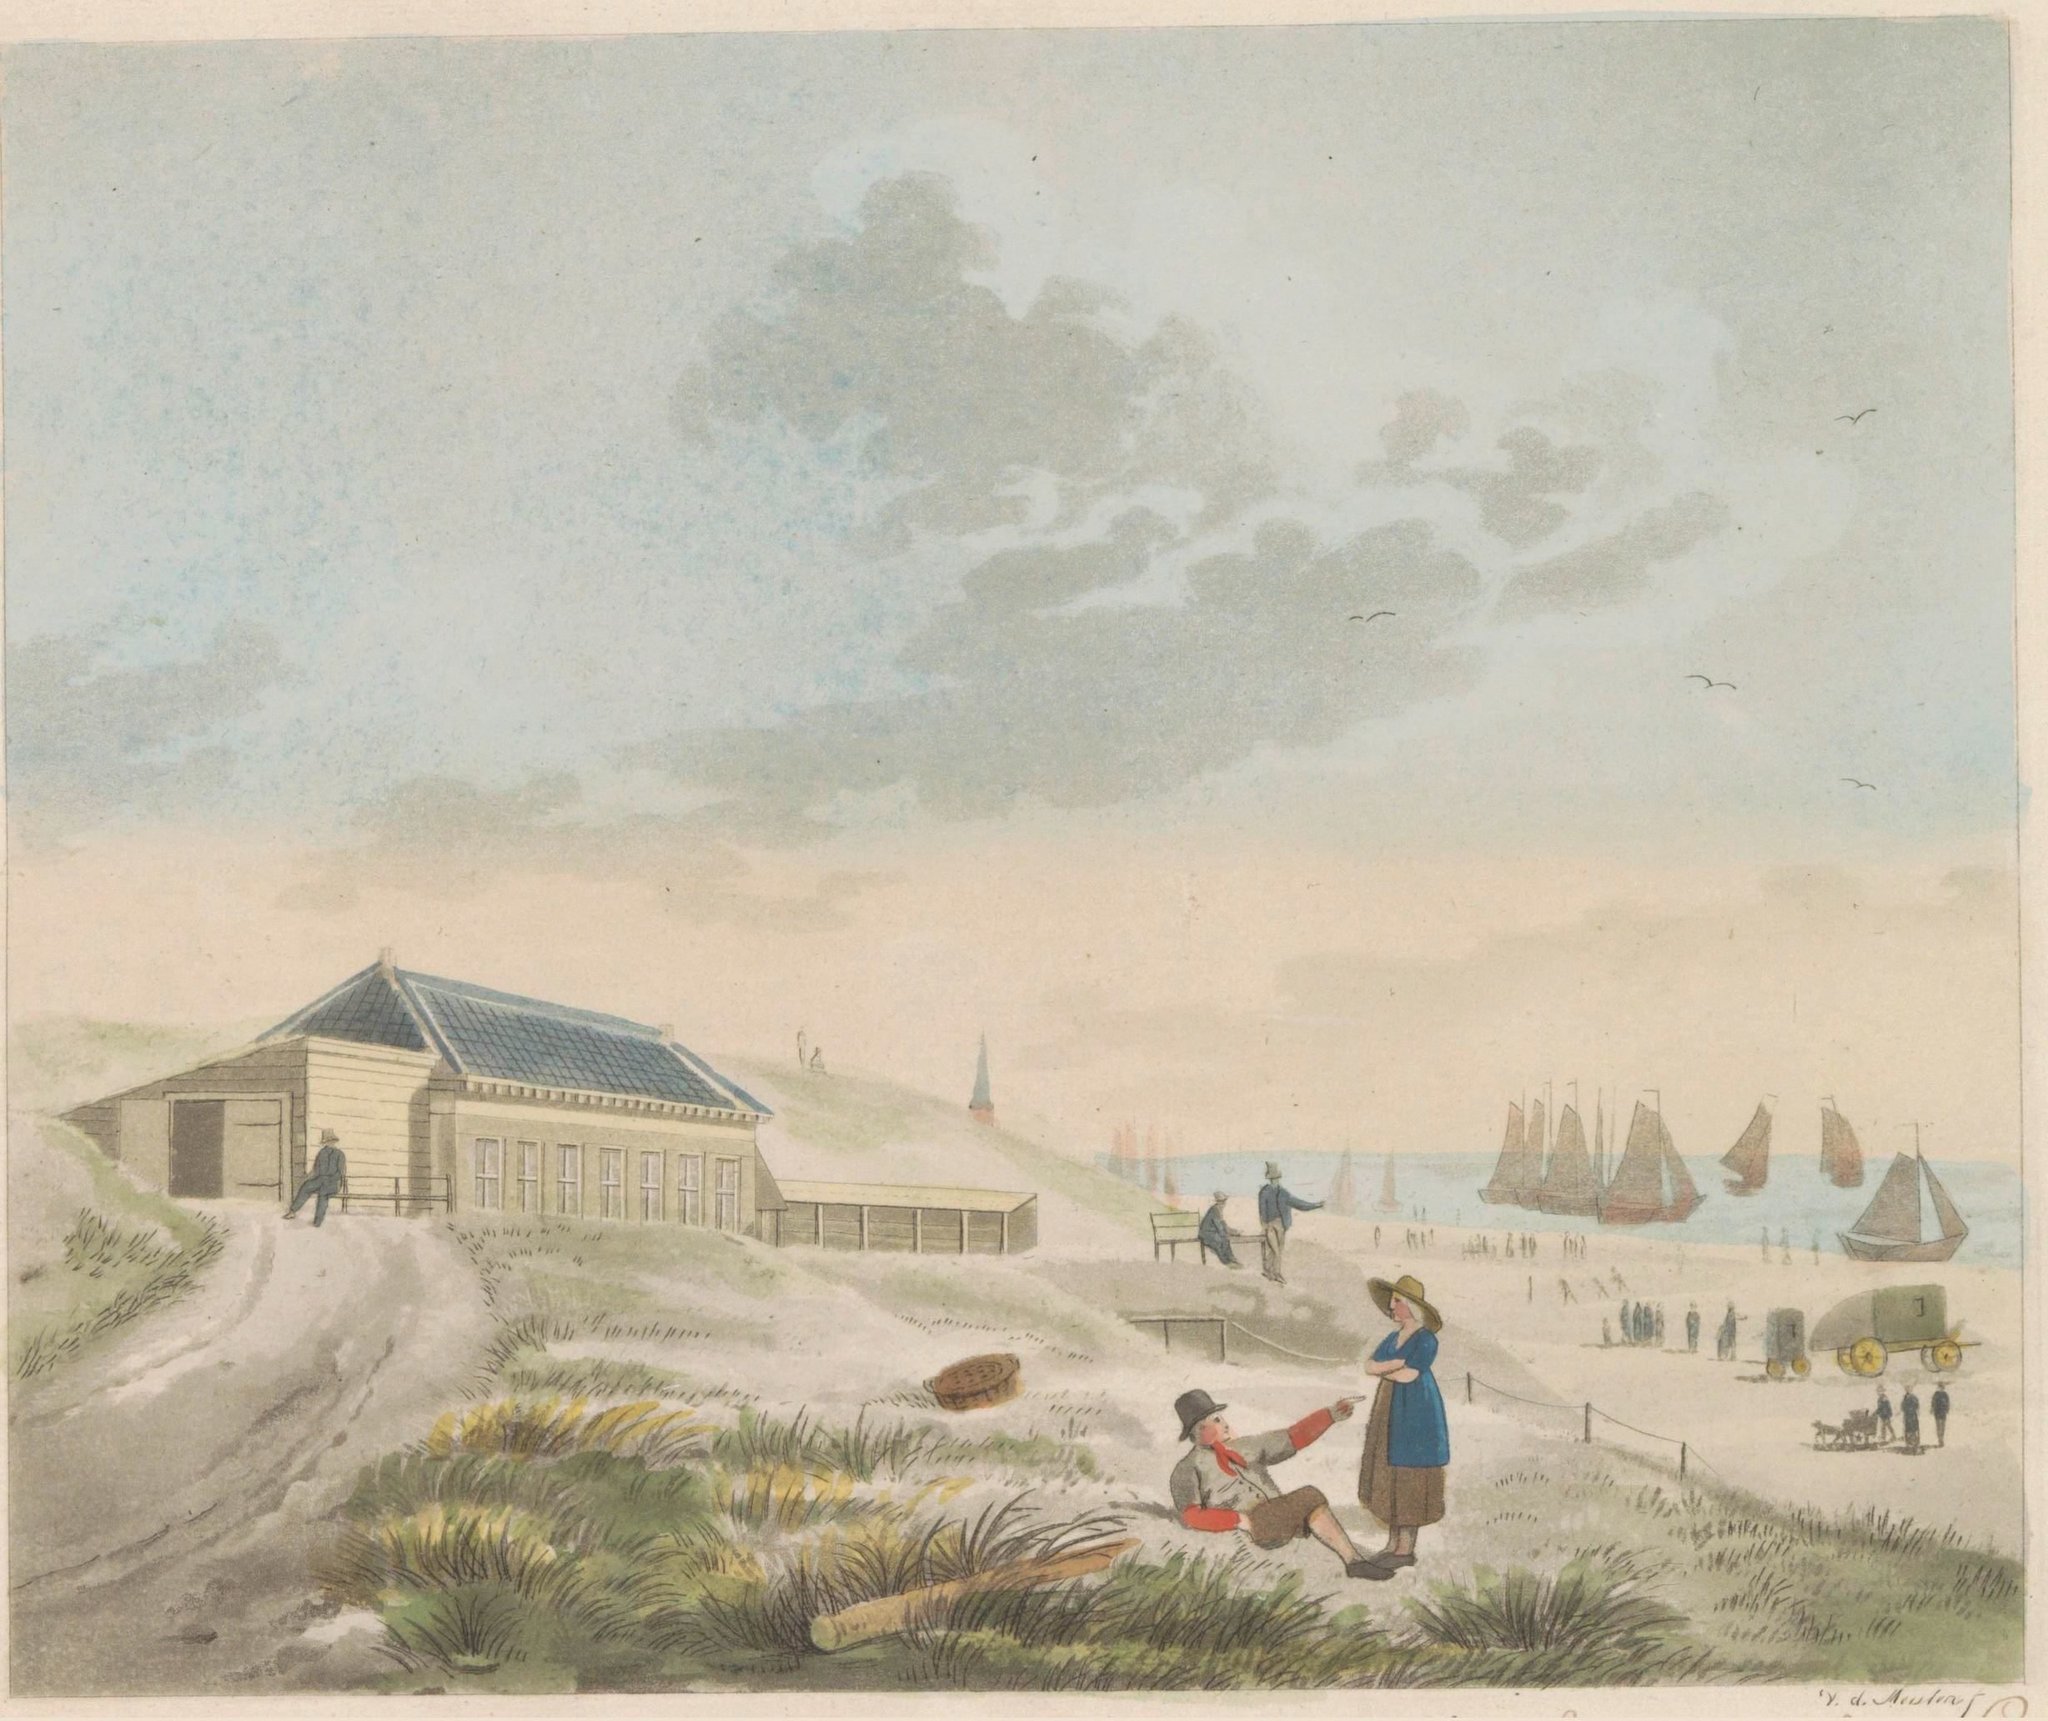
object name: print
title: Gezigt van het strand en de duinen te Scheveningen en Voorstelling van het badhuis van den heer Pronk / Vue du rivage et des dunes a Scheveninge et representation des Bains appartement à mons.r Pronk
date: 1824-1830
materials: paper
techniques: aquatint, etching, hand coloring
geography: netherlands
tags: beach (as place of recreation)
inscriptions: inscription: ‘Gezigt van het strand en de duinen te Scheveningen en Voorstelling van het badhuis van den heer Pronk / Vue du rivage et des dunes a Scheveninge et representation des Bains appartement à mons.r Pronk / chez E: Maaskamp à Amsterdam’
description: Gezicht op de duinen en het strand bij Scheveningen en het badhuis van de heer Pronk, ca. 1825. Onderdeel van een plaatwerk uit ca. 1824-1825 met 74 (ongenummerde) platen van de belangrijkste topografische gezichten en verschillende zeden en gewoonten in het Verenigd Koninkrijk der Nederlanden.